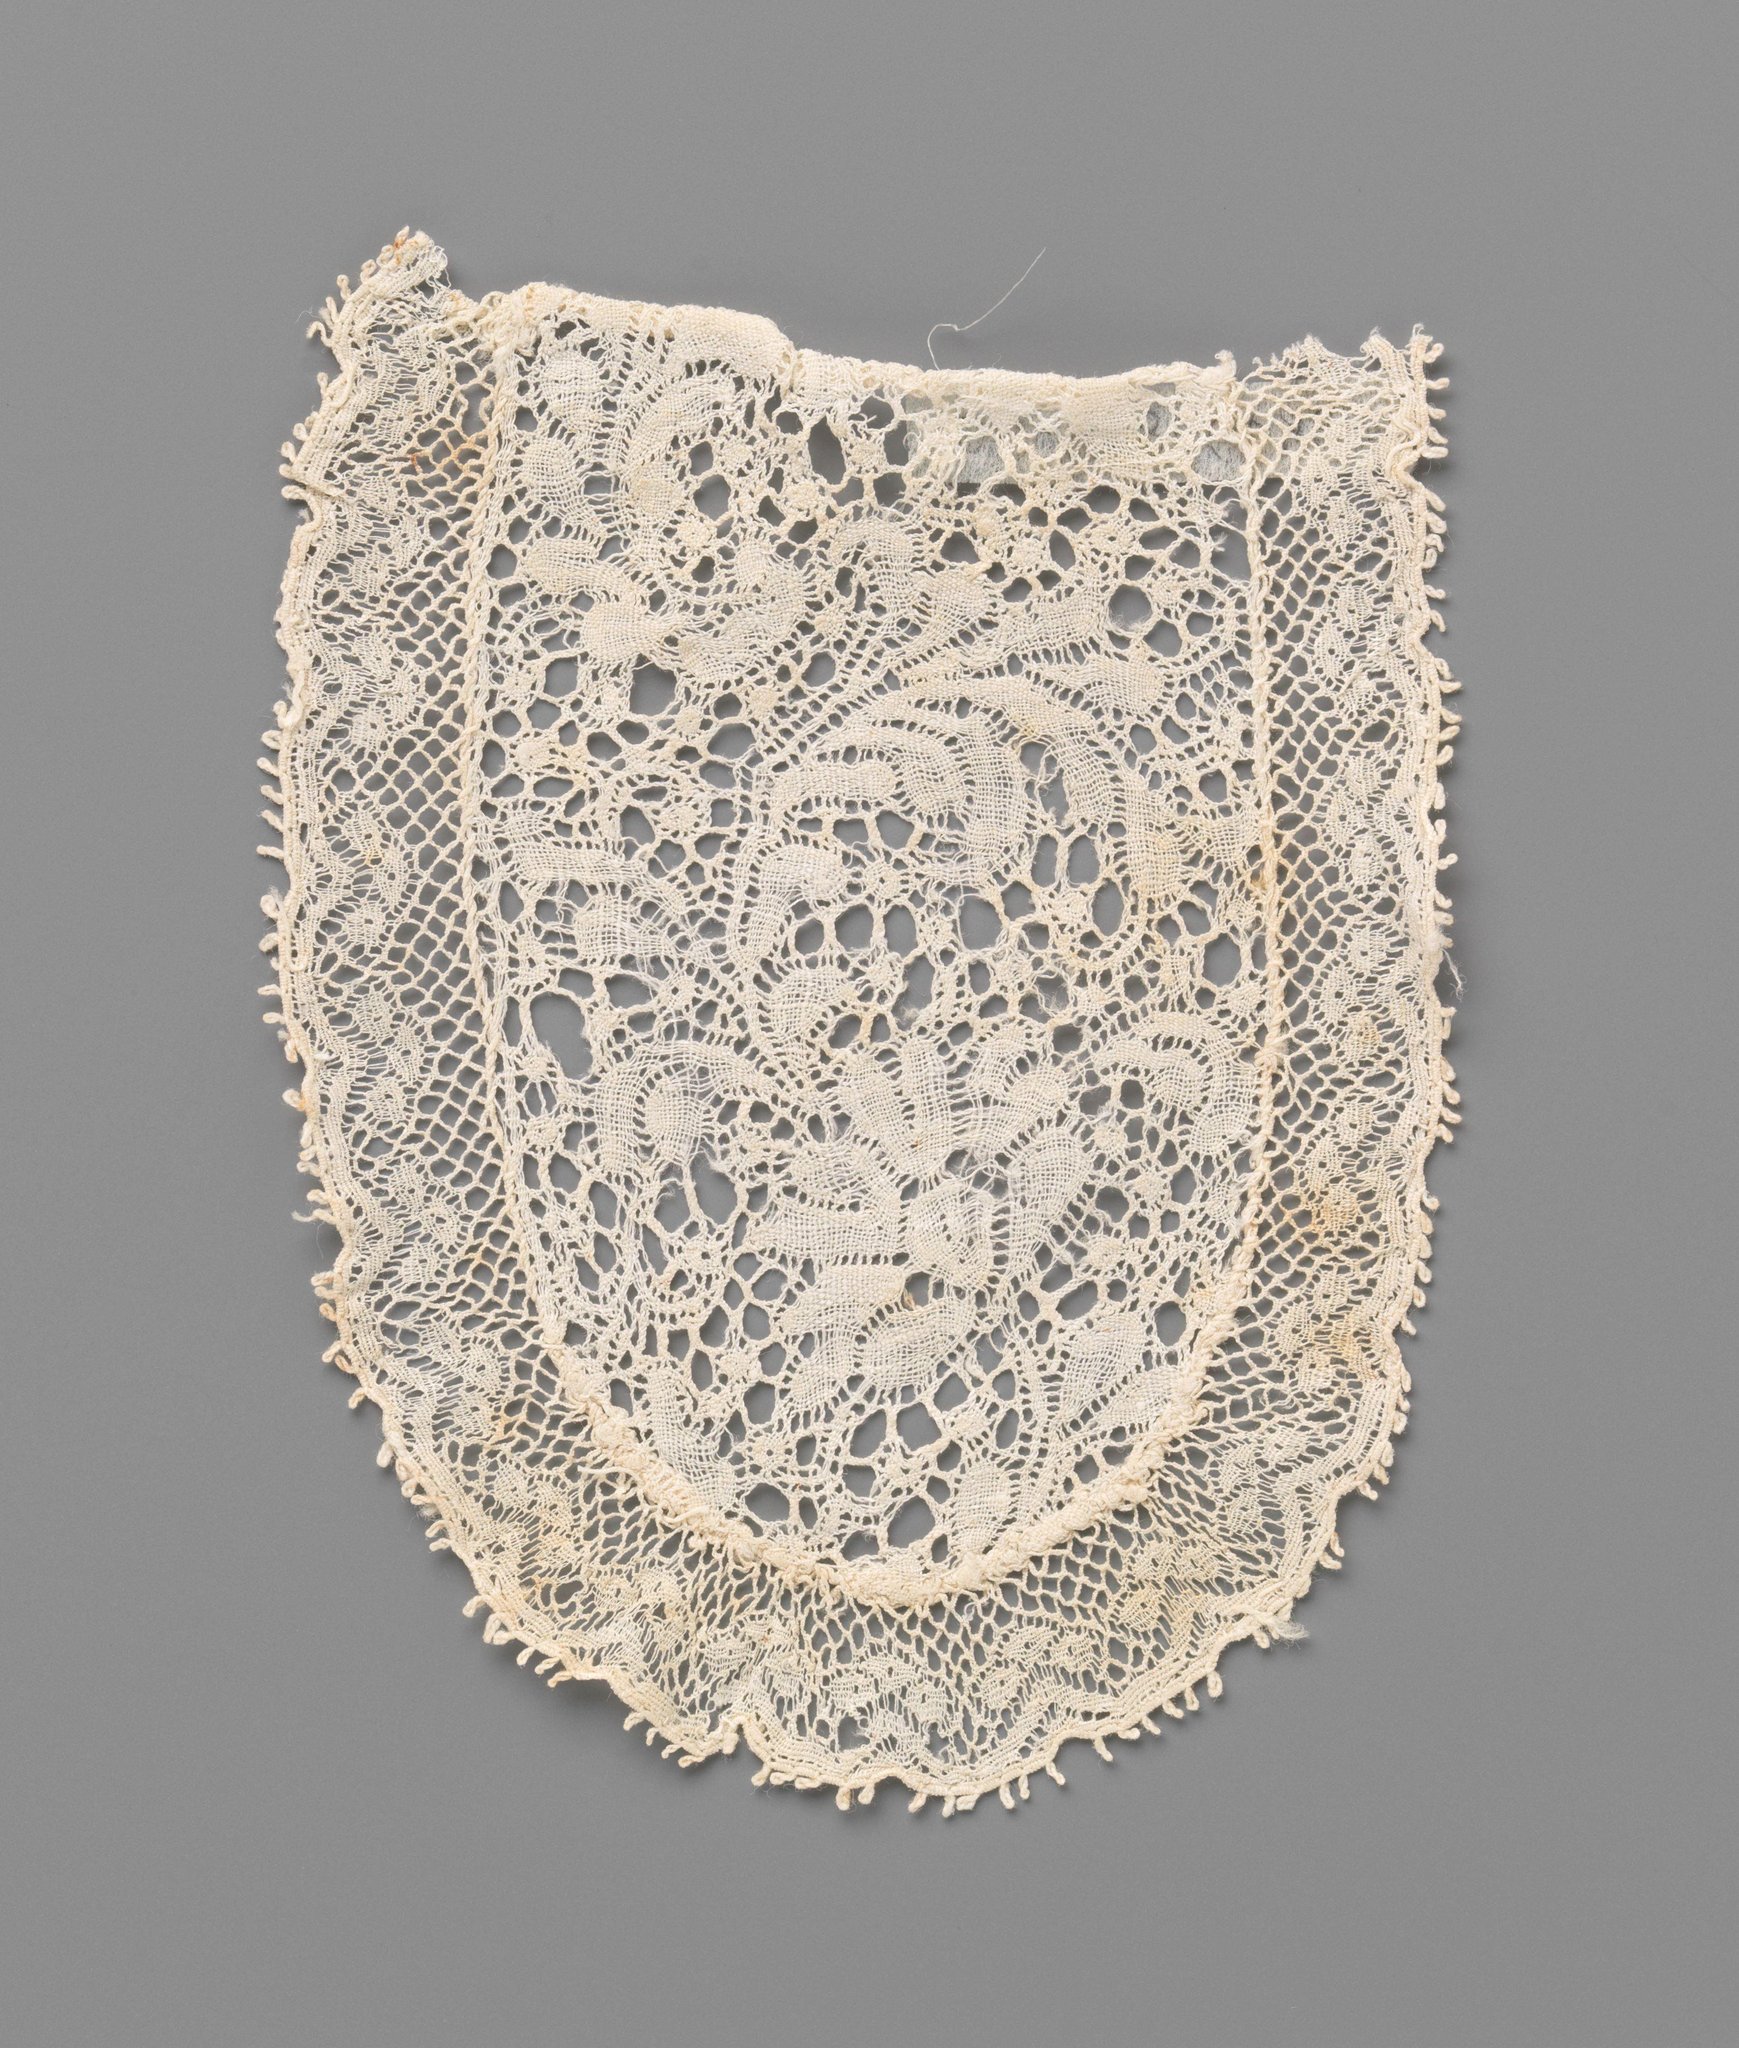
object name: jabot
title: Jabot van kloskant met een golf van een waaiervormige bloem en gevederd blad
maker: Anonymous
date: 1720-1749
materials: linen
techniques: lace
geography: southern netherlands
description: Een kleine jabot van naturelkleurige kloskant, Binche-kant met een randje Valenciennes-kant. Het model is rechthoekig met één afgeronde korte zijde, als een halve ovaal. Het Binche-kantpatroon bestaat uit een gebogen bloemstengel, met een waaiervormige bloem, waaruit een groot gevederd blad ontspringt dat in tegenovergestelde richting afbuigt. De motieven zijn met elkaar verbonden door een siergrond, een sneeuwvlokkengrond. De motieven zijn gemaakt in linnenslag met opengewerkte randjes. De rechte korte zijde is afgewerkt met een zoompje. De andere zijden zijn afgewerkt met een doorlopend randje van Valenciennes-kant met ruitvormige tralie. Het zich herhalende patroon bestaat uit drie ovaaltjes op de toppen van aaneengeschakelde boogjes, waarlangs een schulpenrandje loopt die is afgewerkt met picots.